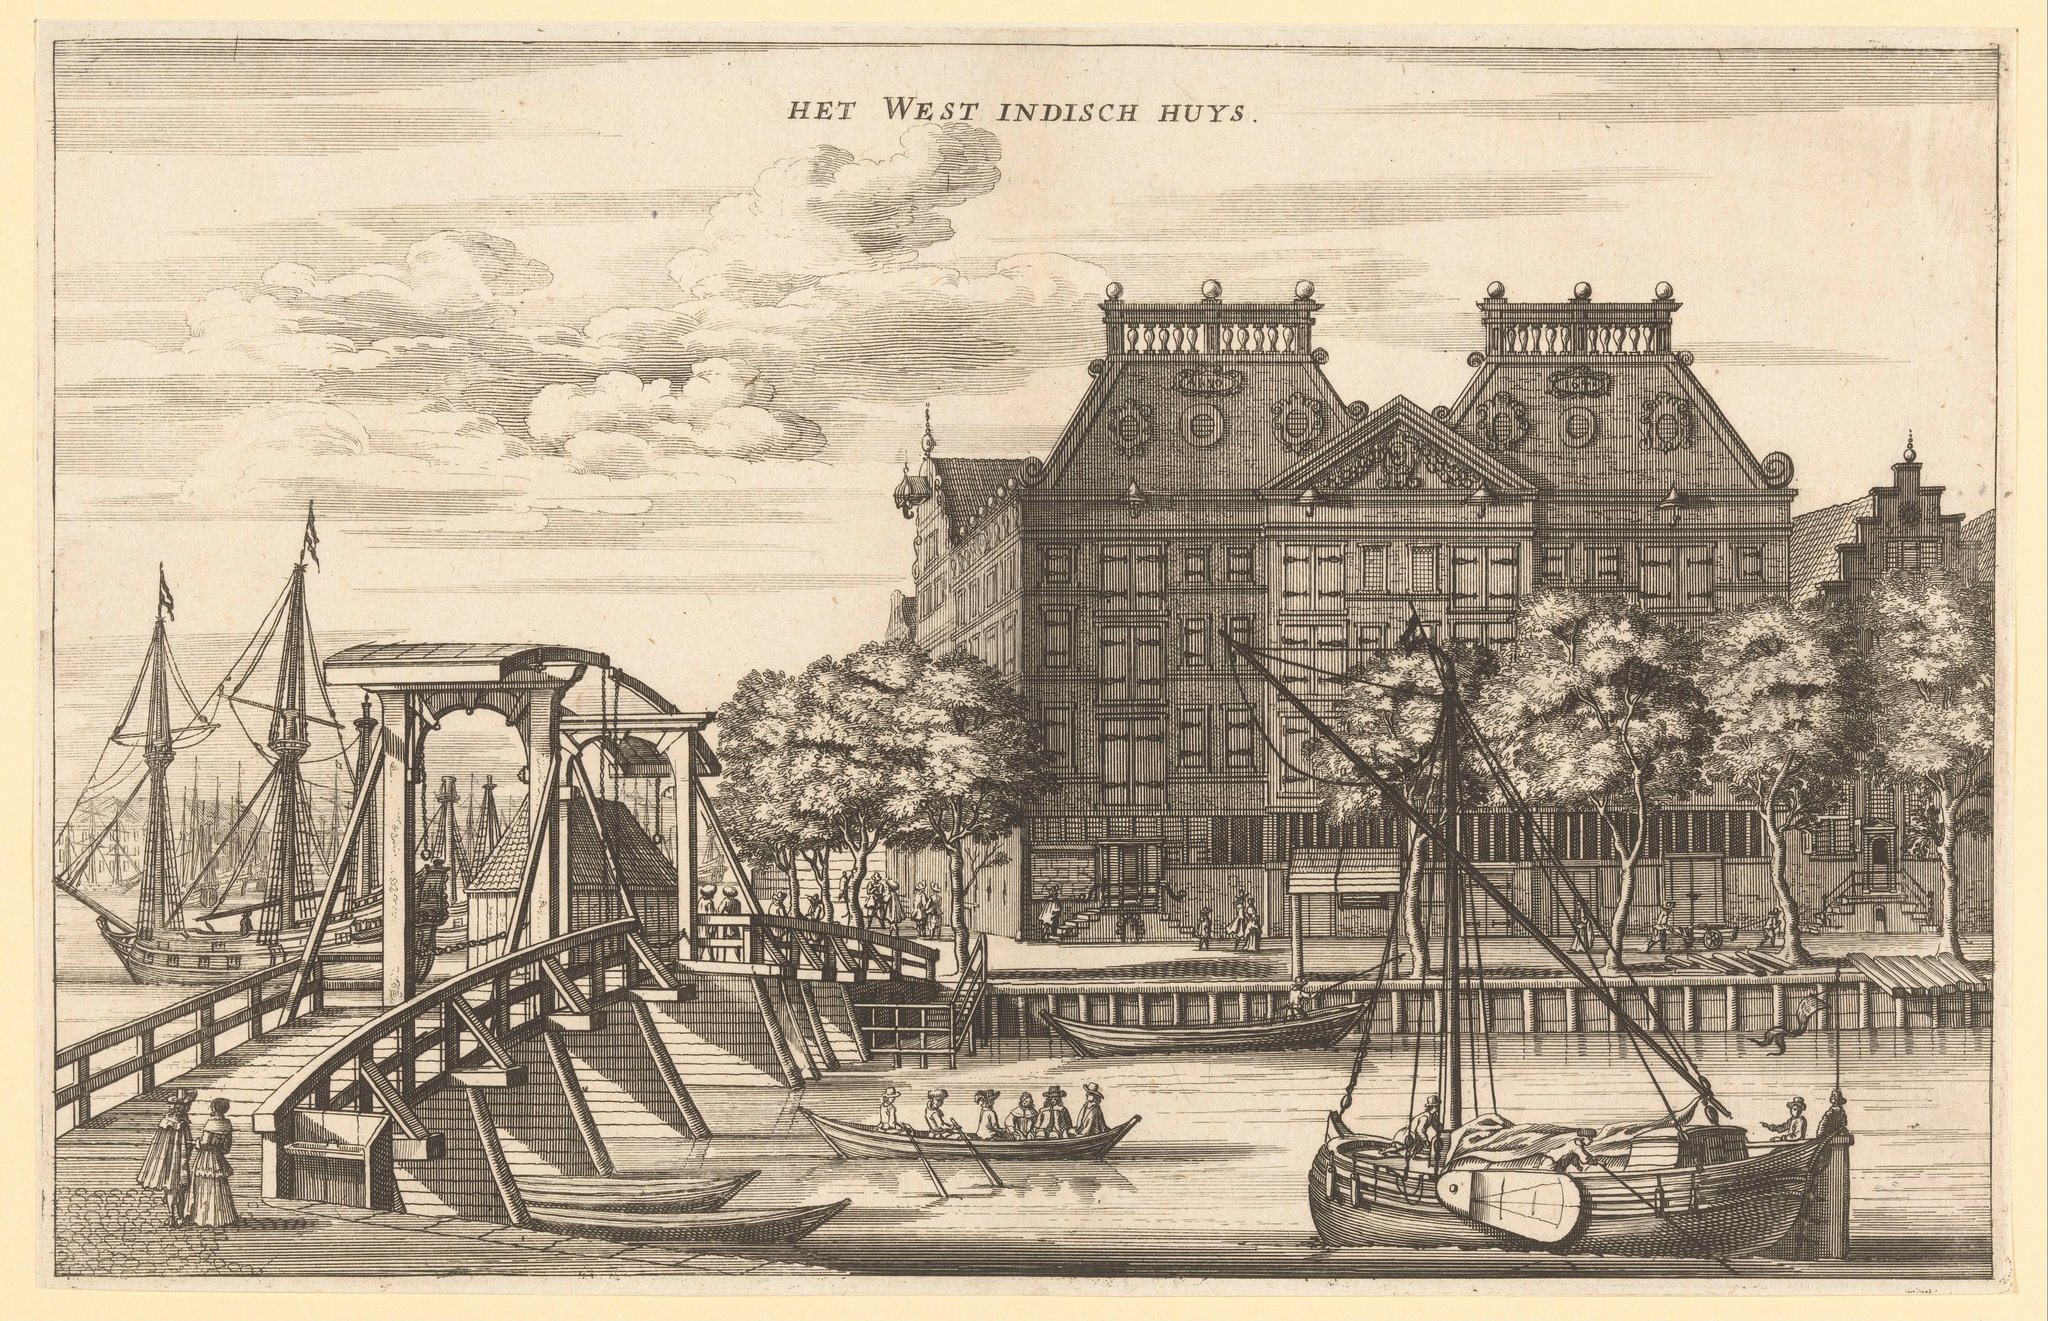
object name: print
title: Het West Indisch Huys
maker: jacob van meurs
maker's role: draughtsman, print maker, publisher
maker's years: 1619-1680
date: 1663-1664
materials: paper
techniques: engraving, etching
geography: amsterdam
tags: warehouse (~ harbour), trade-company, bridge in city across river, canal, etc. (+ city(-scape) with figures, staffage), canals, waters (in city) (+ city(-scape) with figures, staffage), street (+ city(-scape) with figures, staffage)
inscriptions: collector's mark: Lugt 195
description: Huidige staat van prent ook gebruikt in: Dapper, Olfert. Historische beschryving der stadt Amsterdam: waer in de voornaemste geschiedenissen (na een kort verhael van gansch Hollant en d'omleggende dorpen (…). Amsterdam: Jacob van Meurs, 1663.* En in: Zesen, Philipp von. Beschreibung der Stadt Amsterdam: darinnen von derselben ersten Ursprunge bis auf gegenwärtigen Zustand (…). Amsterdam: Joachim Nosche, 1664. * In sommige exemplaren van deze uitgave komt de huidige staat van de prent voor. In andere exemplaren is een latere staat ingebonden, waarop boven de Nederlandse een Franse titel is toegevoegd.